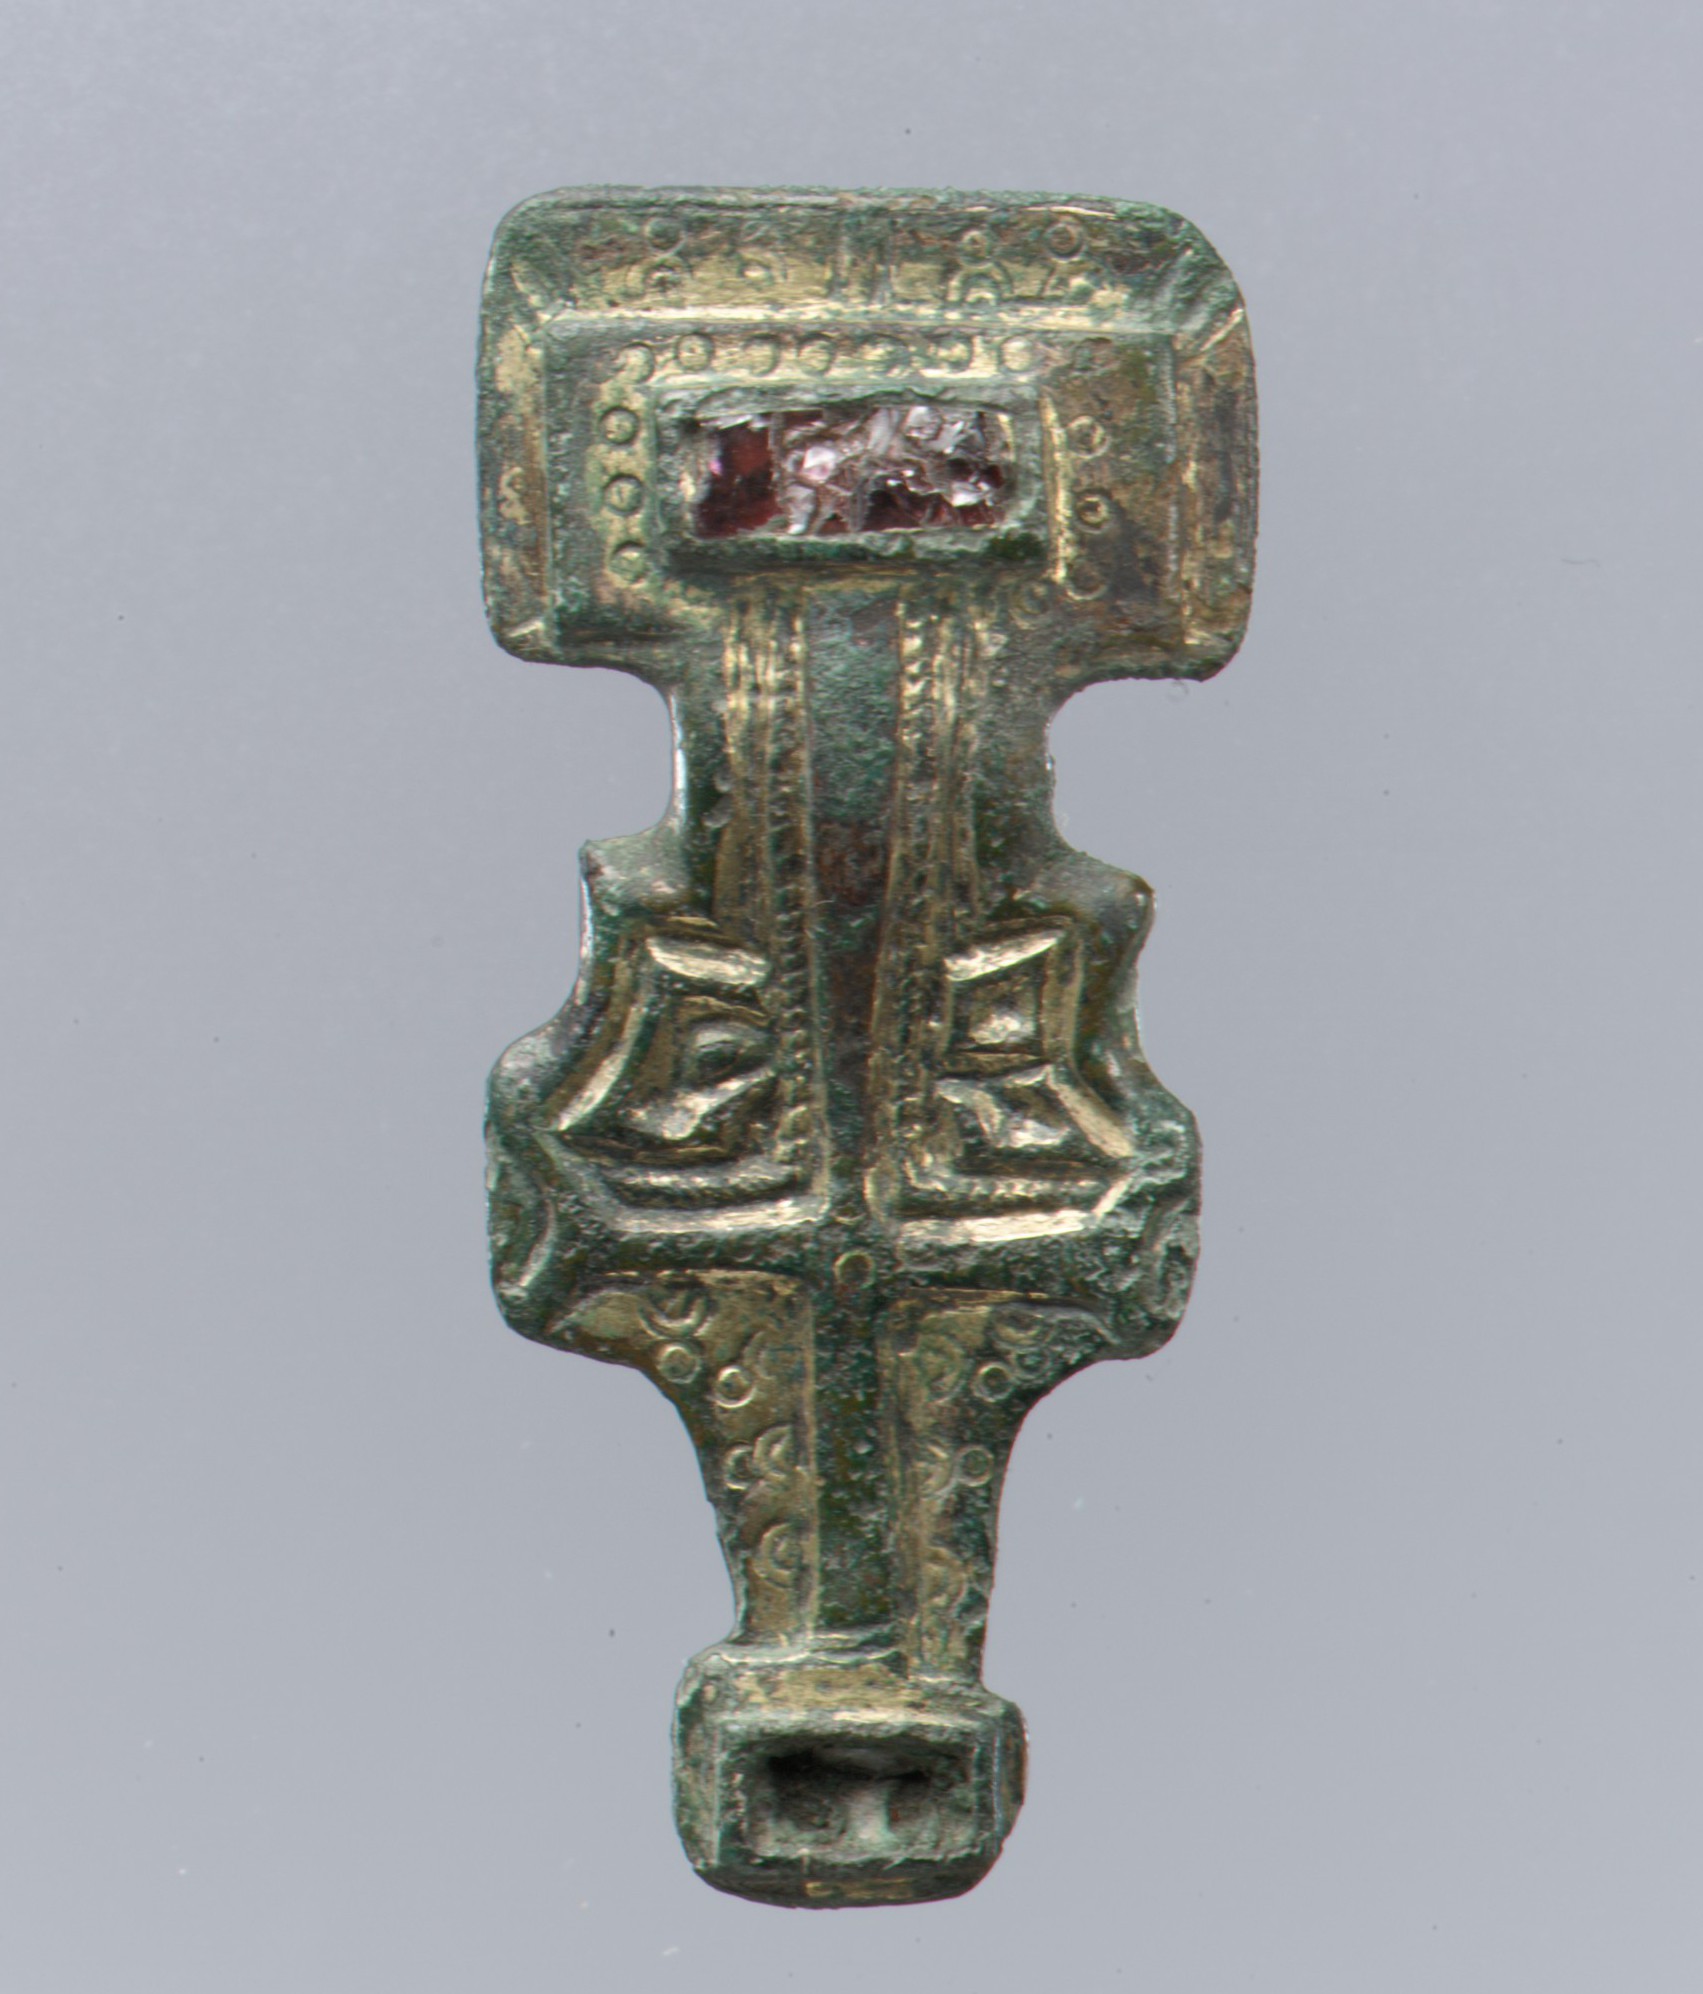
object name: brooch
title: Miniature Square-Headed Brooch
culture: anglo-saxon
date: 501-550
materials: gemstone, iron, silver gilt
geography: england